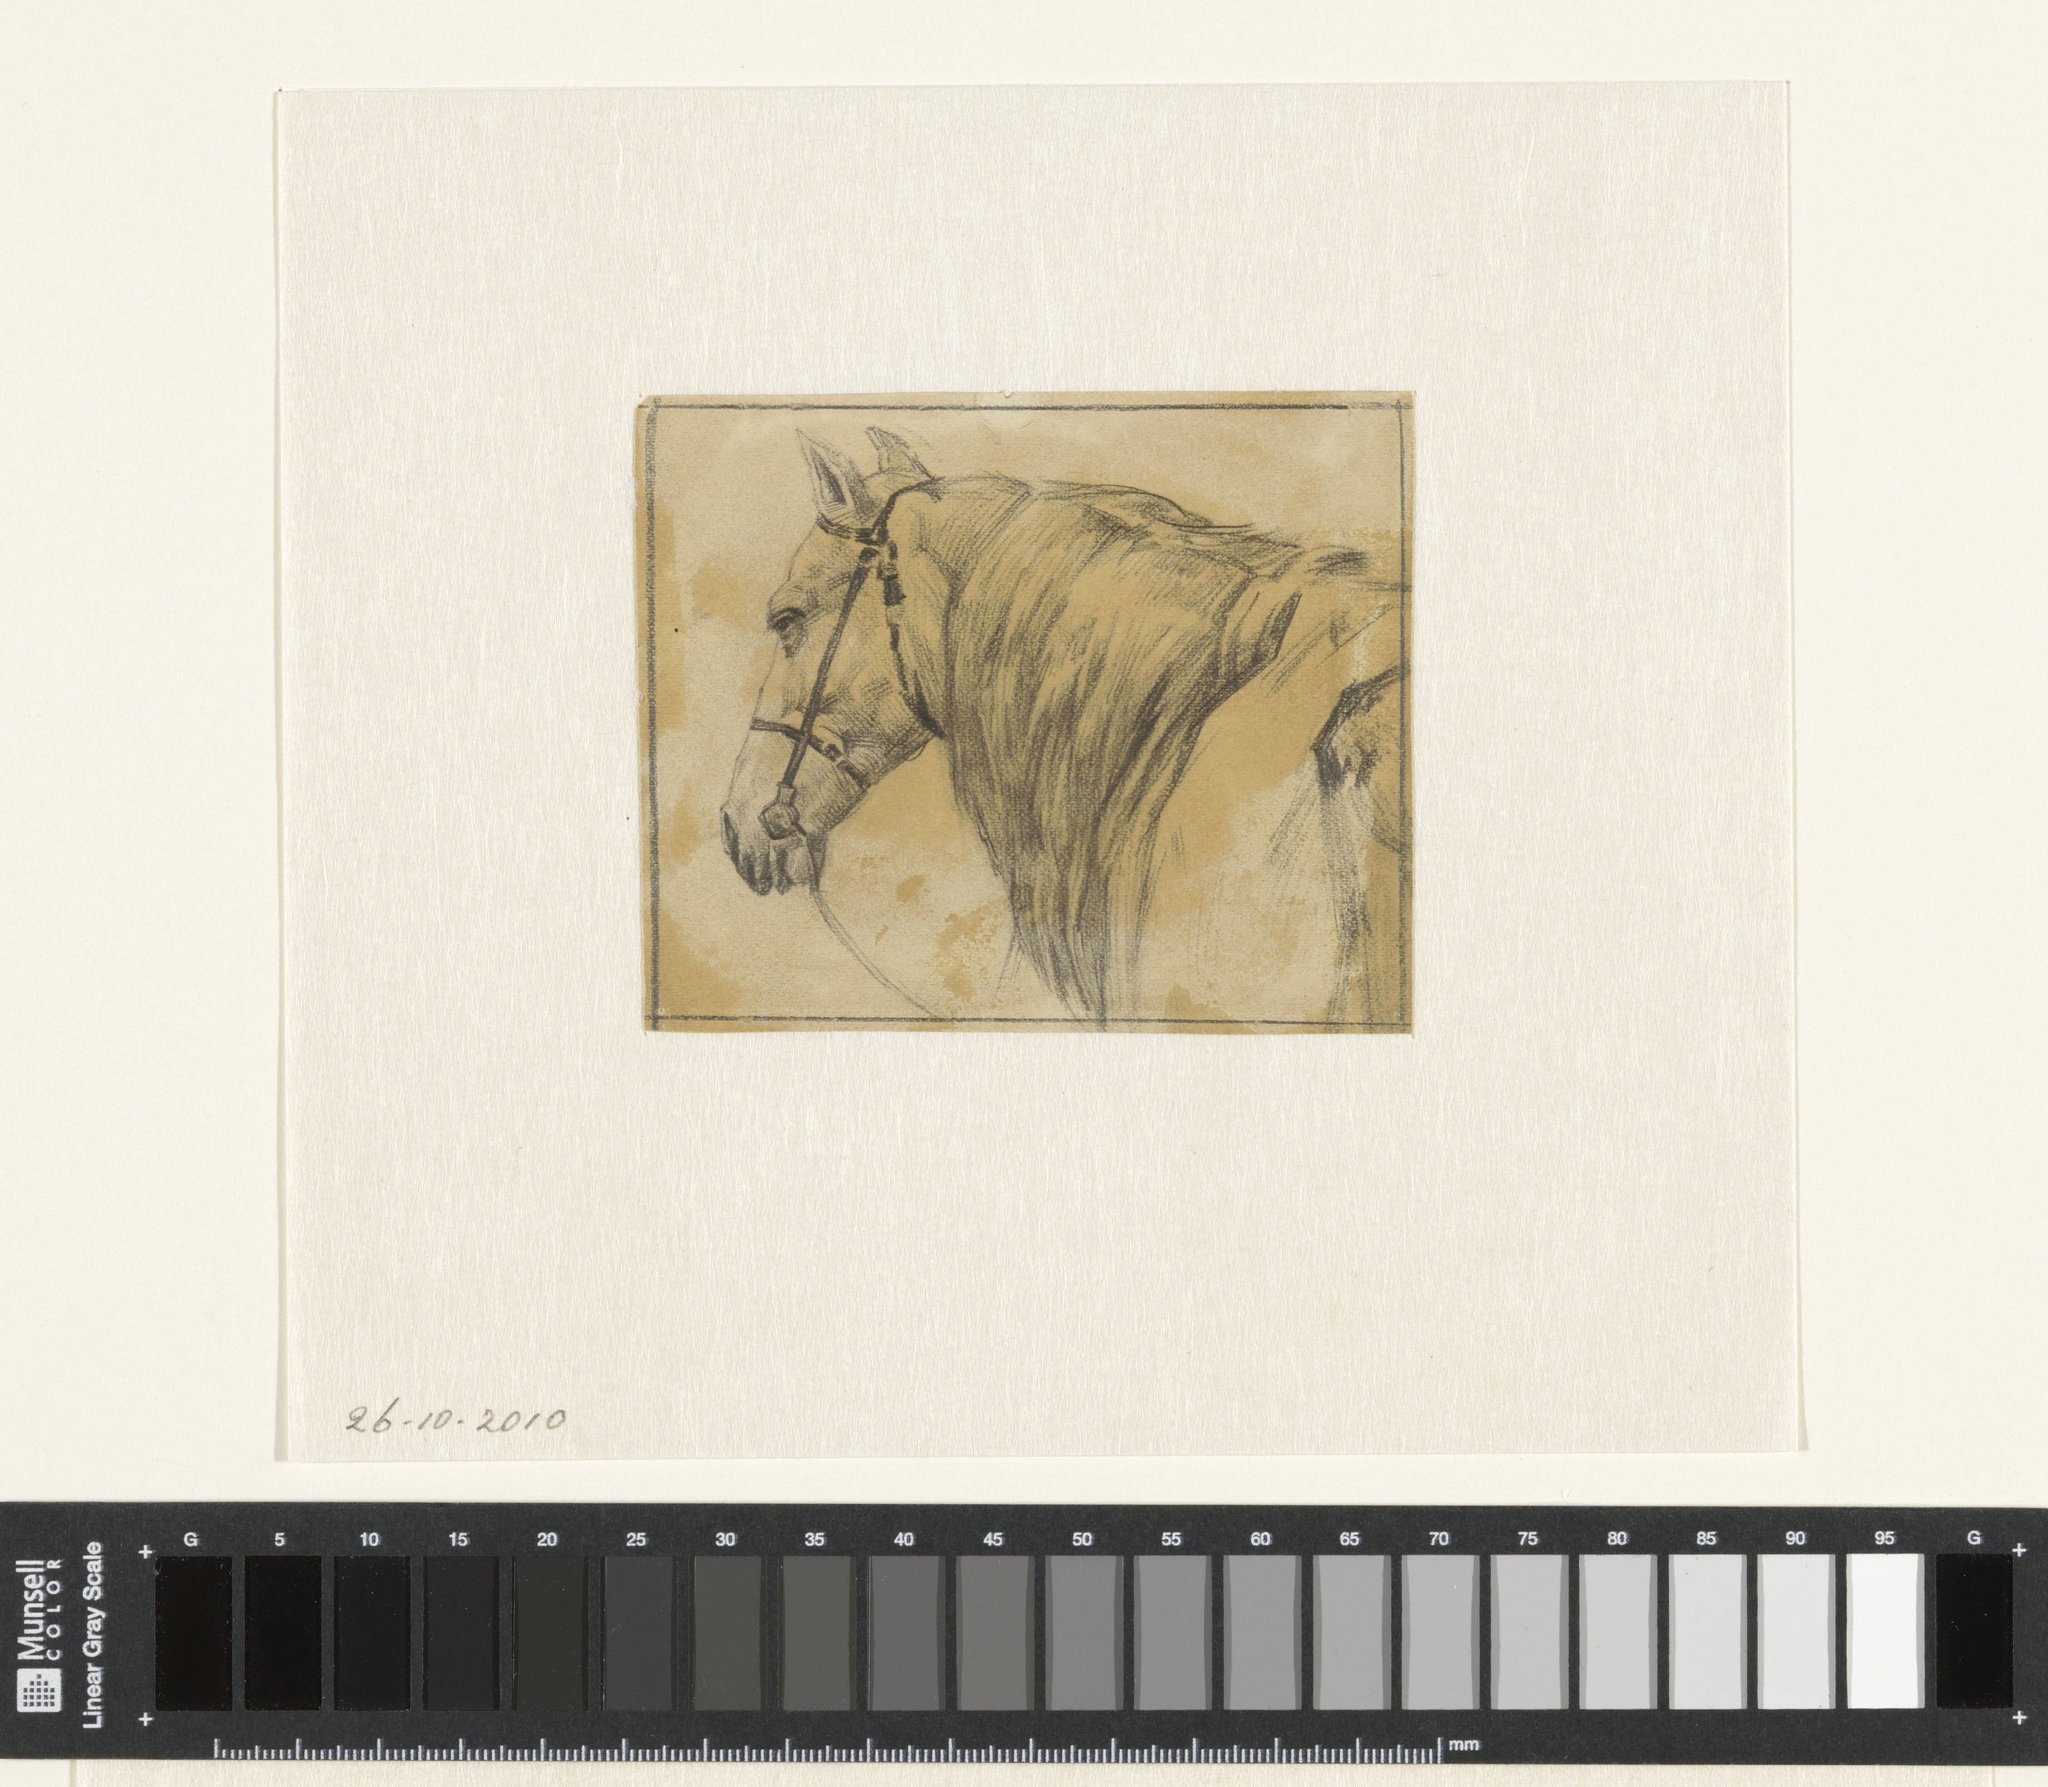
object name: drawing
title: Paard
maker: jan veth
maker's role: designer, draughtsman, painter, print maker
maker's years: 1864-1925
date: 1874-1925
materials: chalk, paper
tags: horse